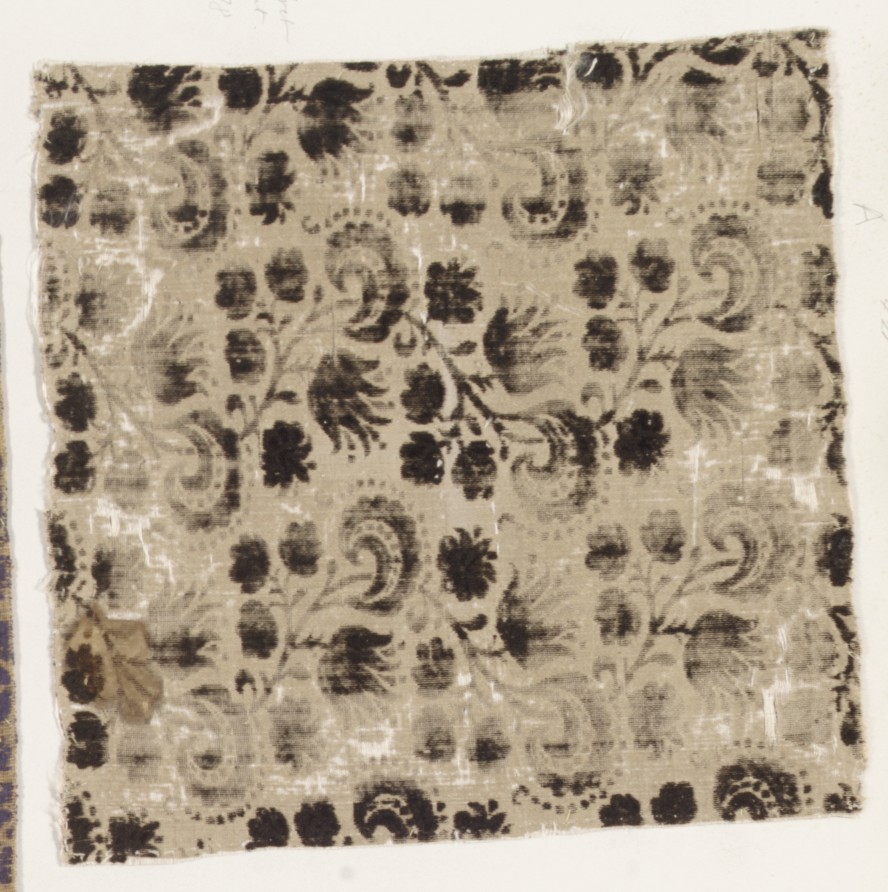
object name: fragment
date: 1501-1600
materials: silk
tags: flowers